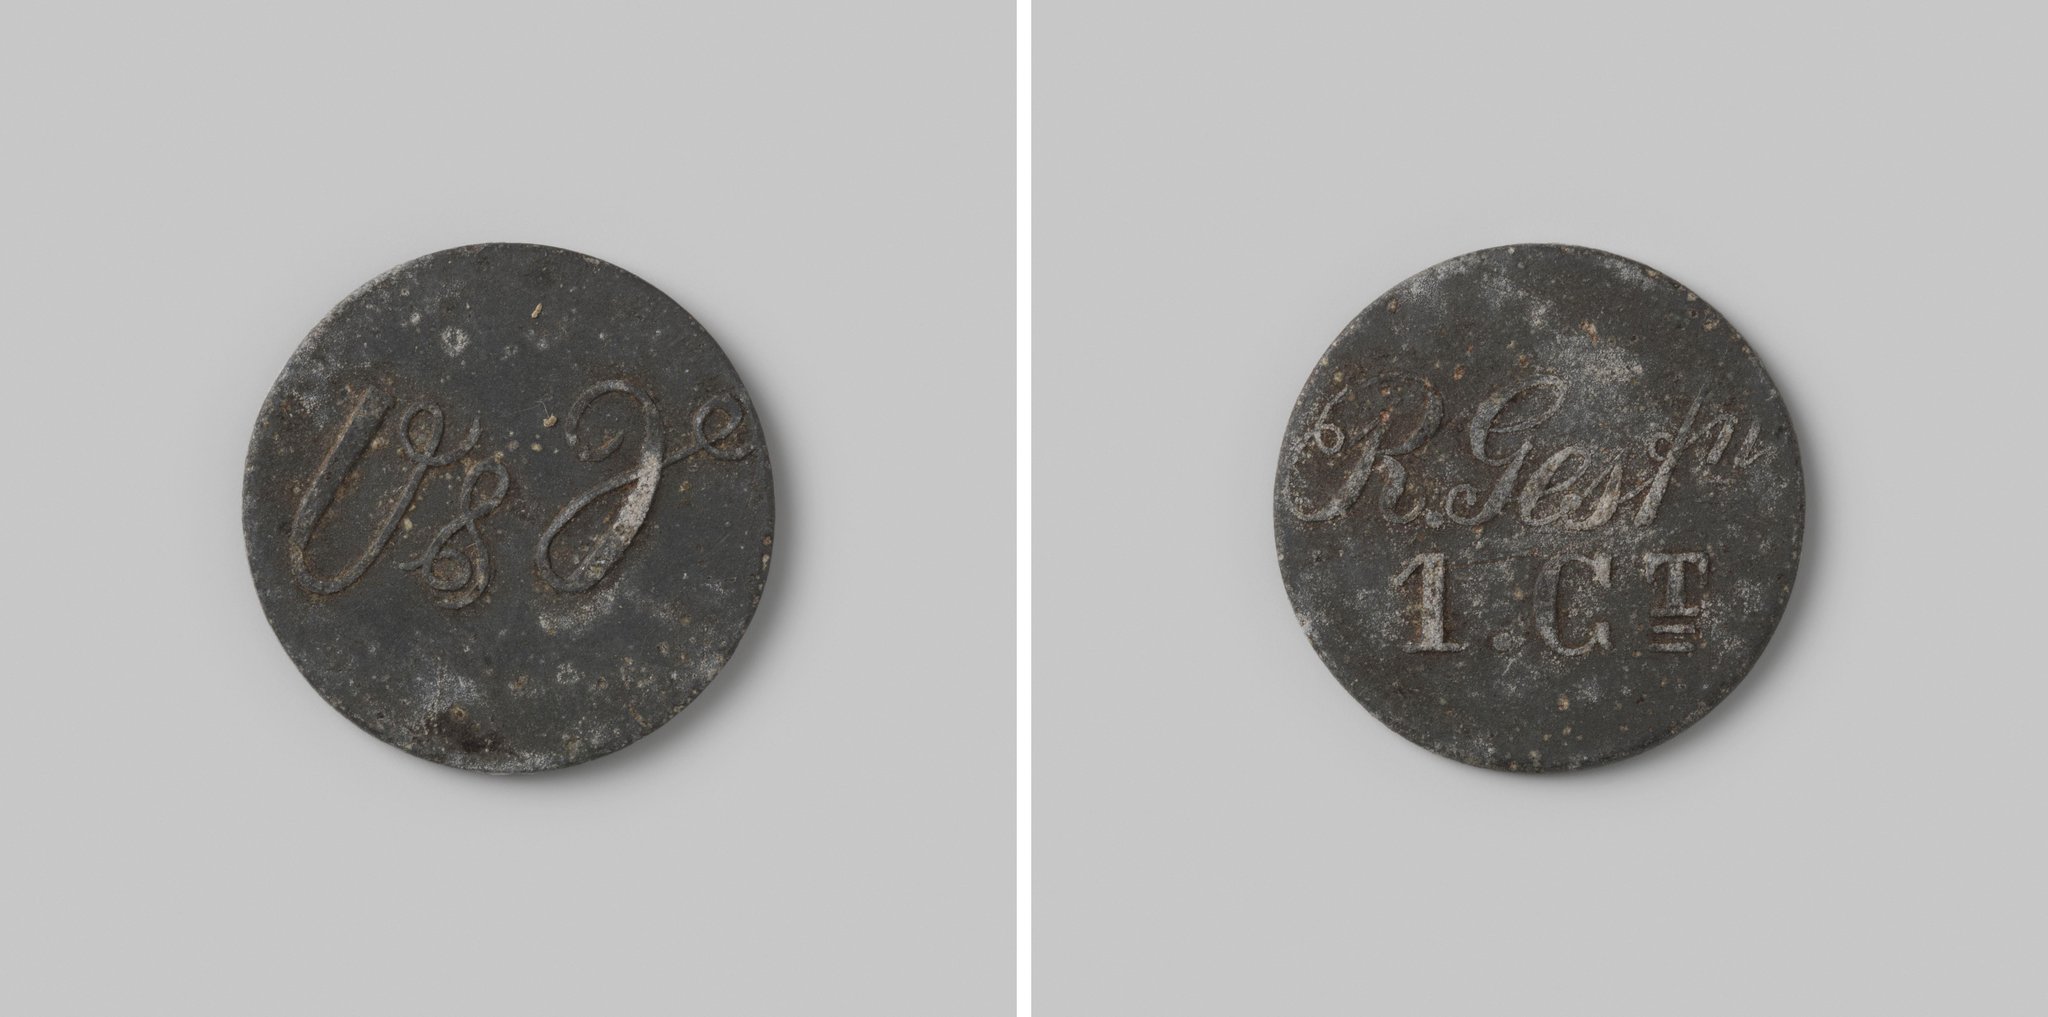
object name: history medal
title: Betaalpenning van 1 cent van de Kolonies Ommerschans en Veenhuizen van de Maatschappij van Weldadigheid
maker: Anonymous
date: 1859-1900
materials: zinc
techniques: striking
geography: netherlands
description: IJzeren penning, op de voorzijde O & V, op de keerzijde R. Gest' / 1 CT